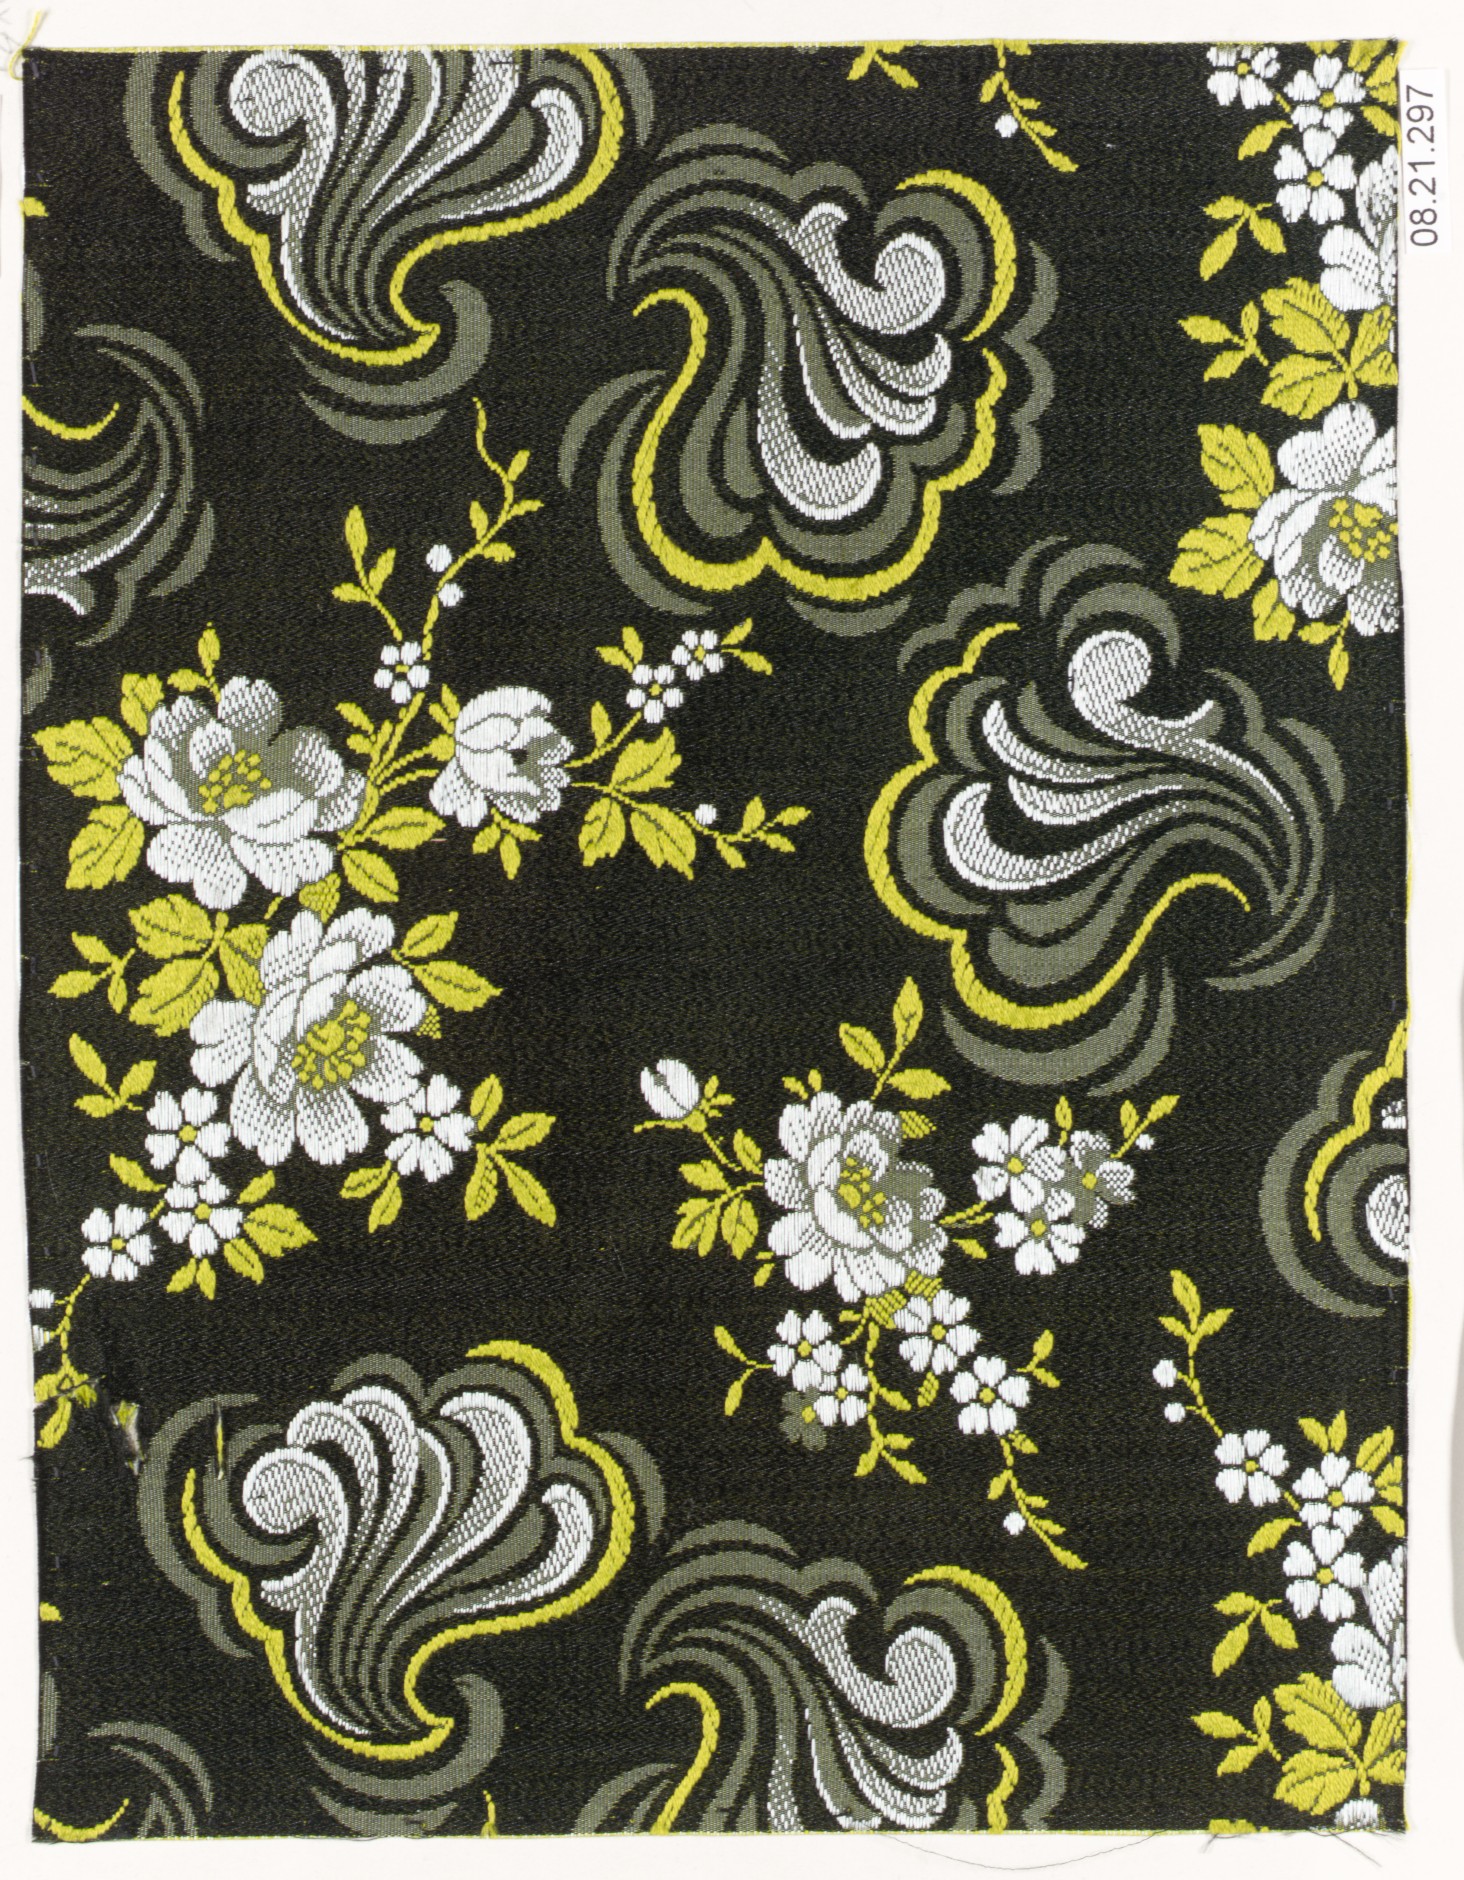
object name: textile sample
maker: Anonymous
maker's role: designer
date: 1900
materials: silk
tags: flowers